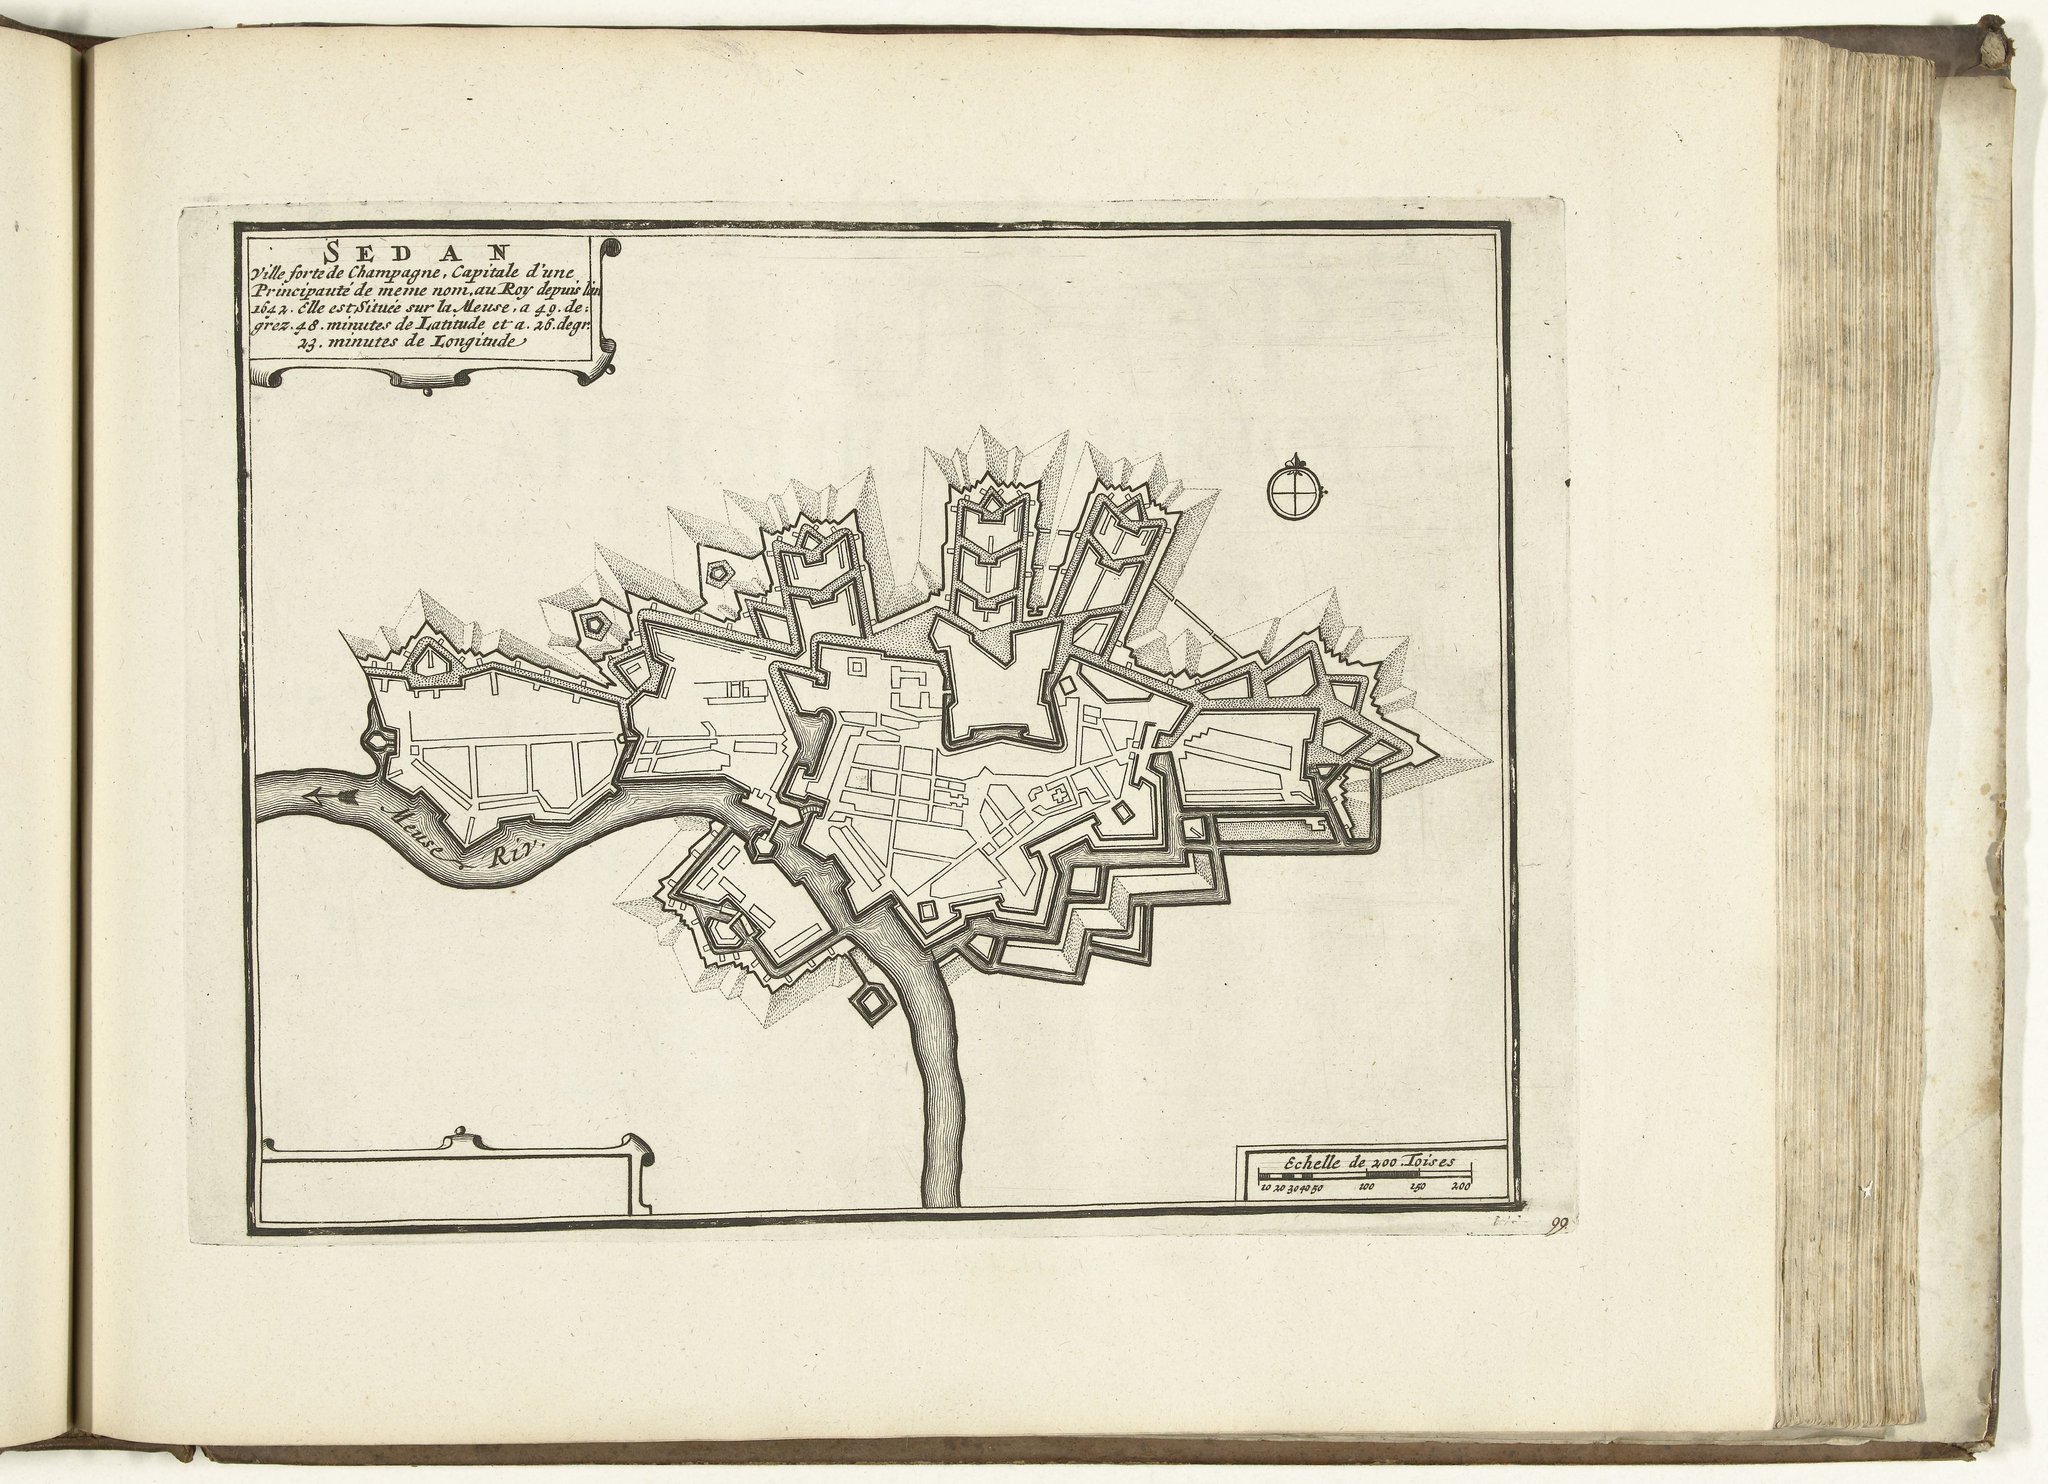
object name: print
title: Sedan Ville forte de Champagne (...)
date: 1726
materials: paper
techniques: engraving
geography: northern netherlands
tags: fortress, maps of cities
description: Plattegrond van de versterkingen om de Franse stad Sedan. Plaat nr. 99 in deel IV van het prentwerk: Les Forces de l'Europe, Asie, Afrique et Amerique ... Comme aussi les Cartes des Côtes de France et d'Espagne uit 1726, dit eerste deel met 238 met de hand genummerde platen van vermaarde sterke steden en vestingen in het kader van de Spaanse Successieoorlog 1701-1713. Voor het merendeel zijn deze platen gekopieerd naar de anonieme Franse platen van vermaarde sterke steden en vestingen: in Les forces de l'Europe en in: Le theatre de la guerre, dans les Pays-Bas, beide oorspronkelijk uitgegeven door Nicolas de Fer te Parijs (1693-1697) in het kader van de Negenjarige Oorlog. Titel en opschriften in het Frans. Rechtsonder sporen van het weggepolijste nummer: 240.